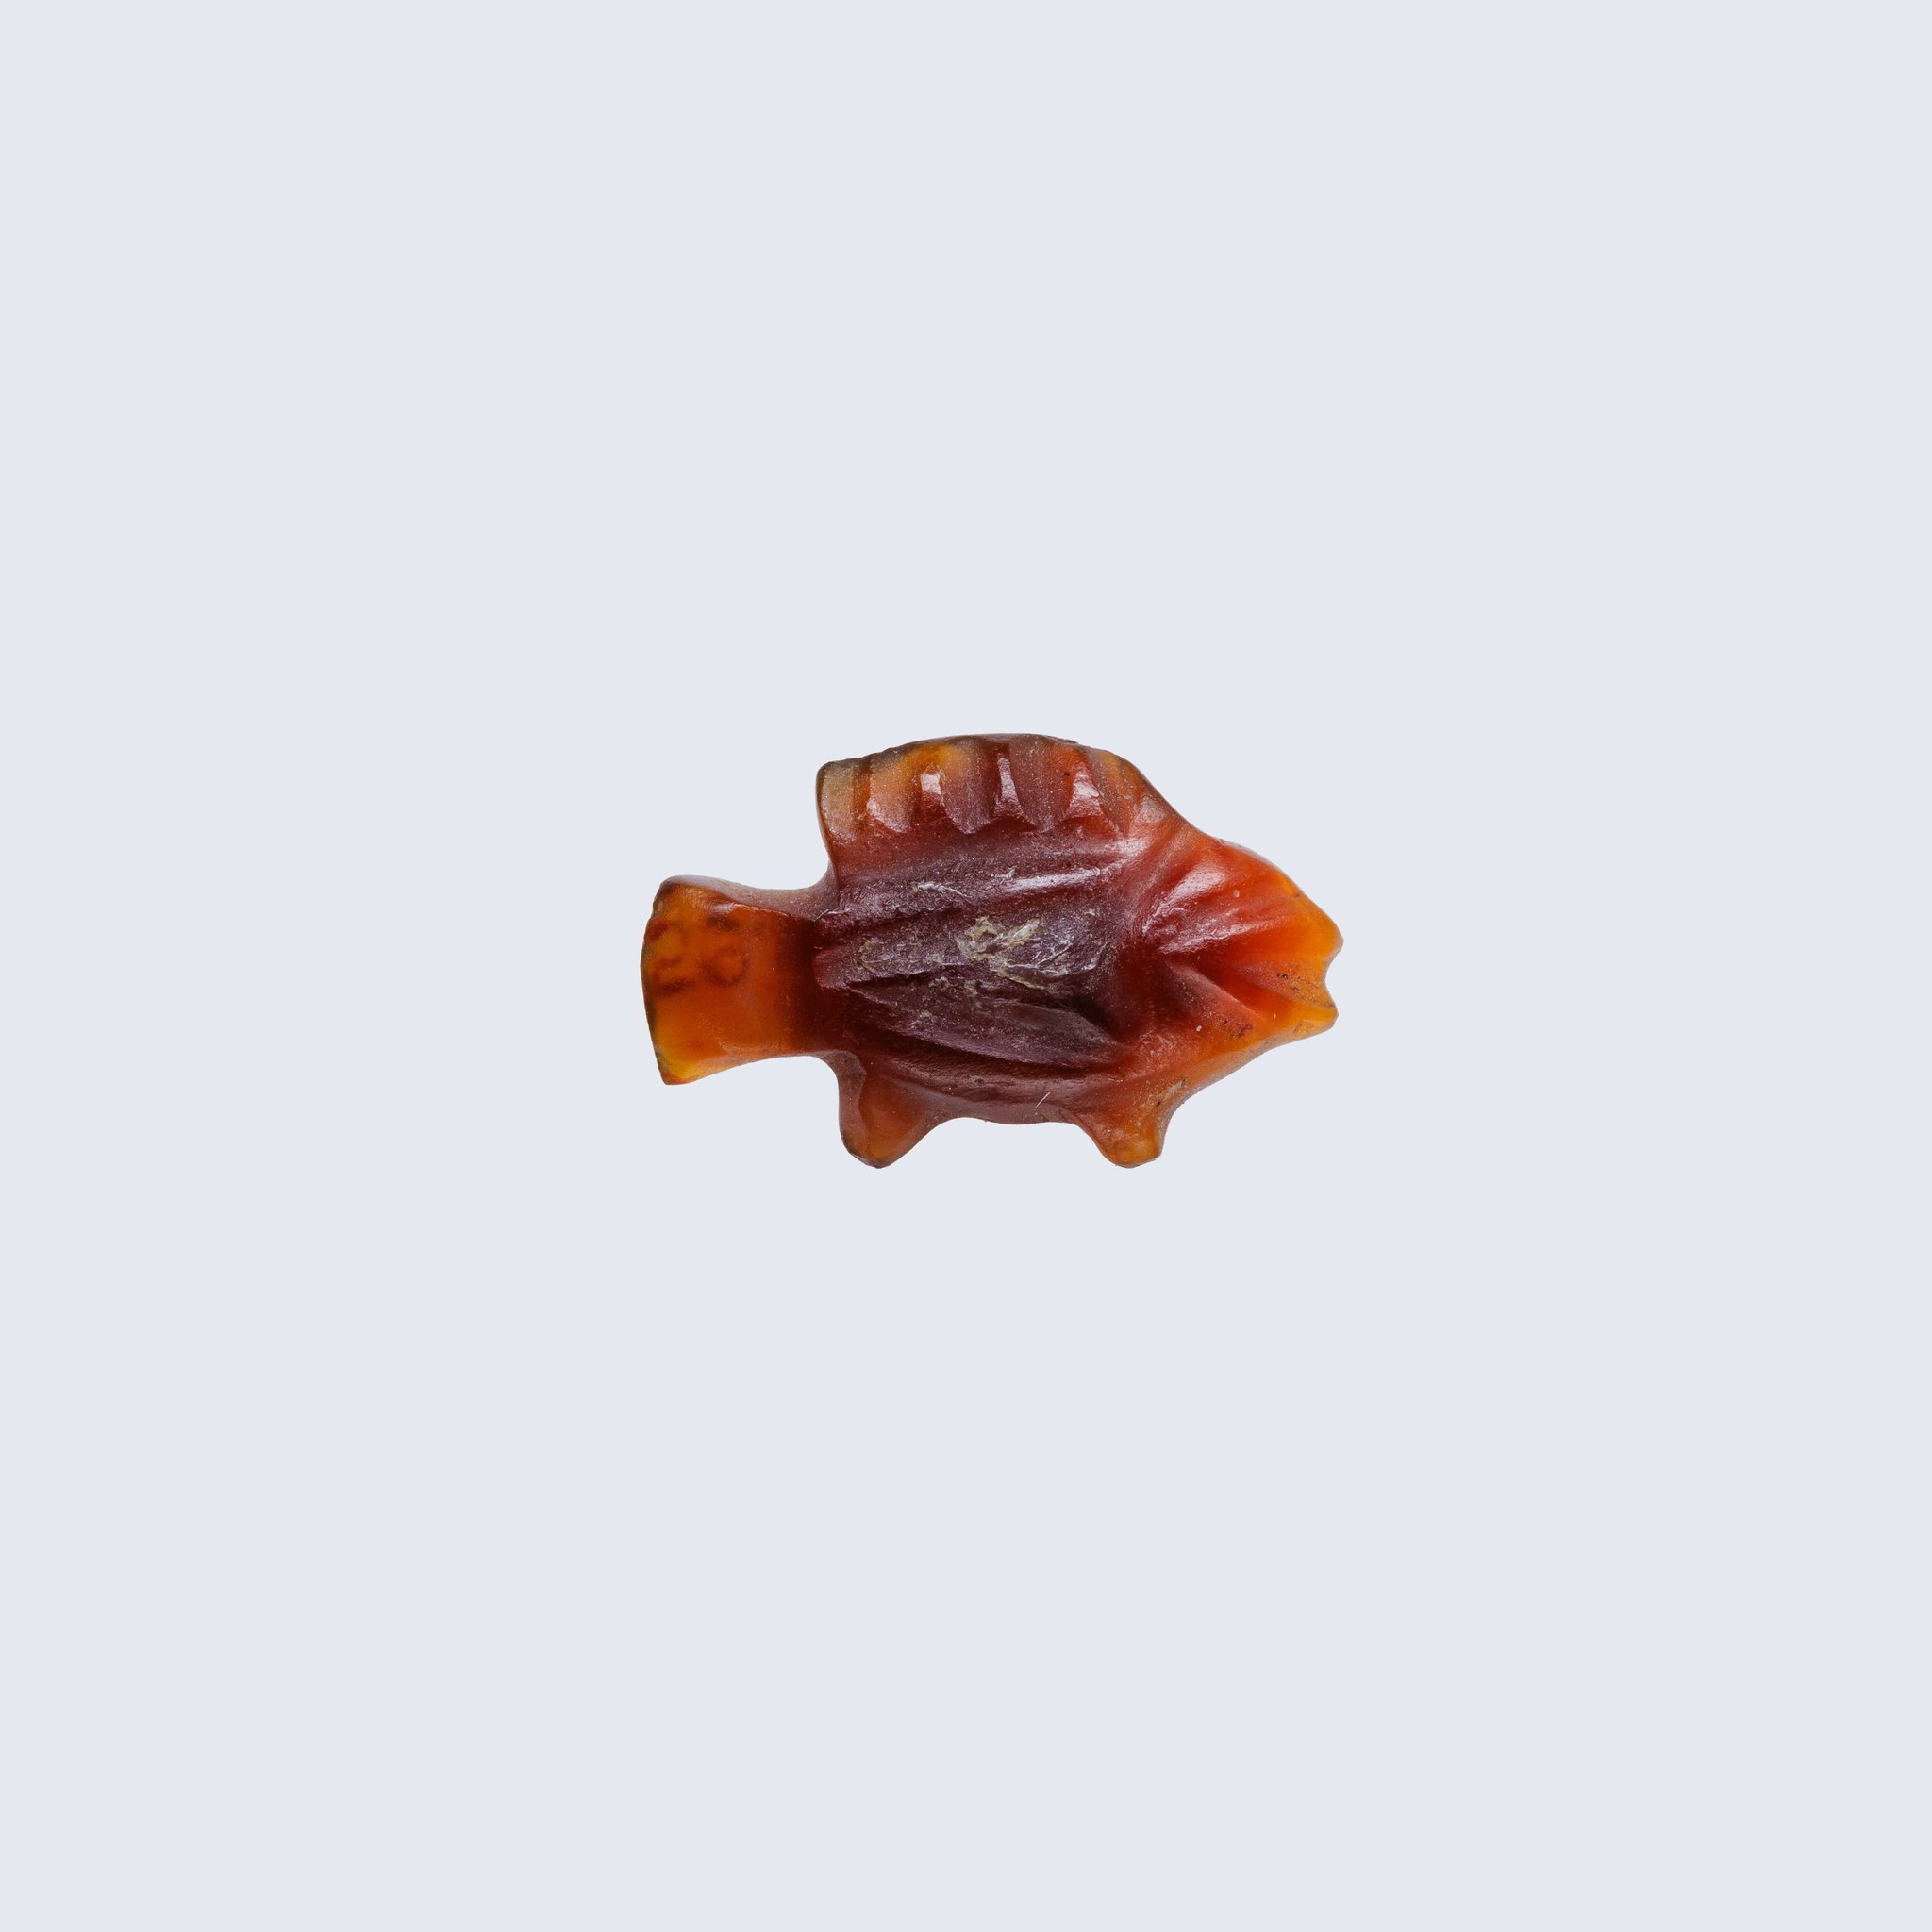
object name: amulet, fish bolti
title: Fish (Bolti) Amulet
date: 2150-1950 BCE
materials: gemstone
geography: southern upper egypt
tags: fish